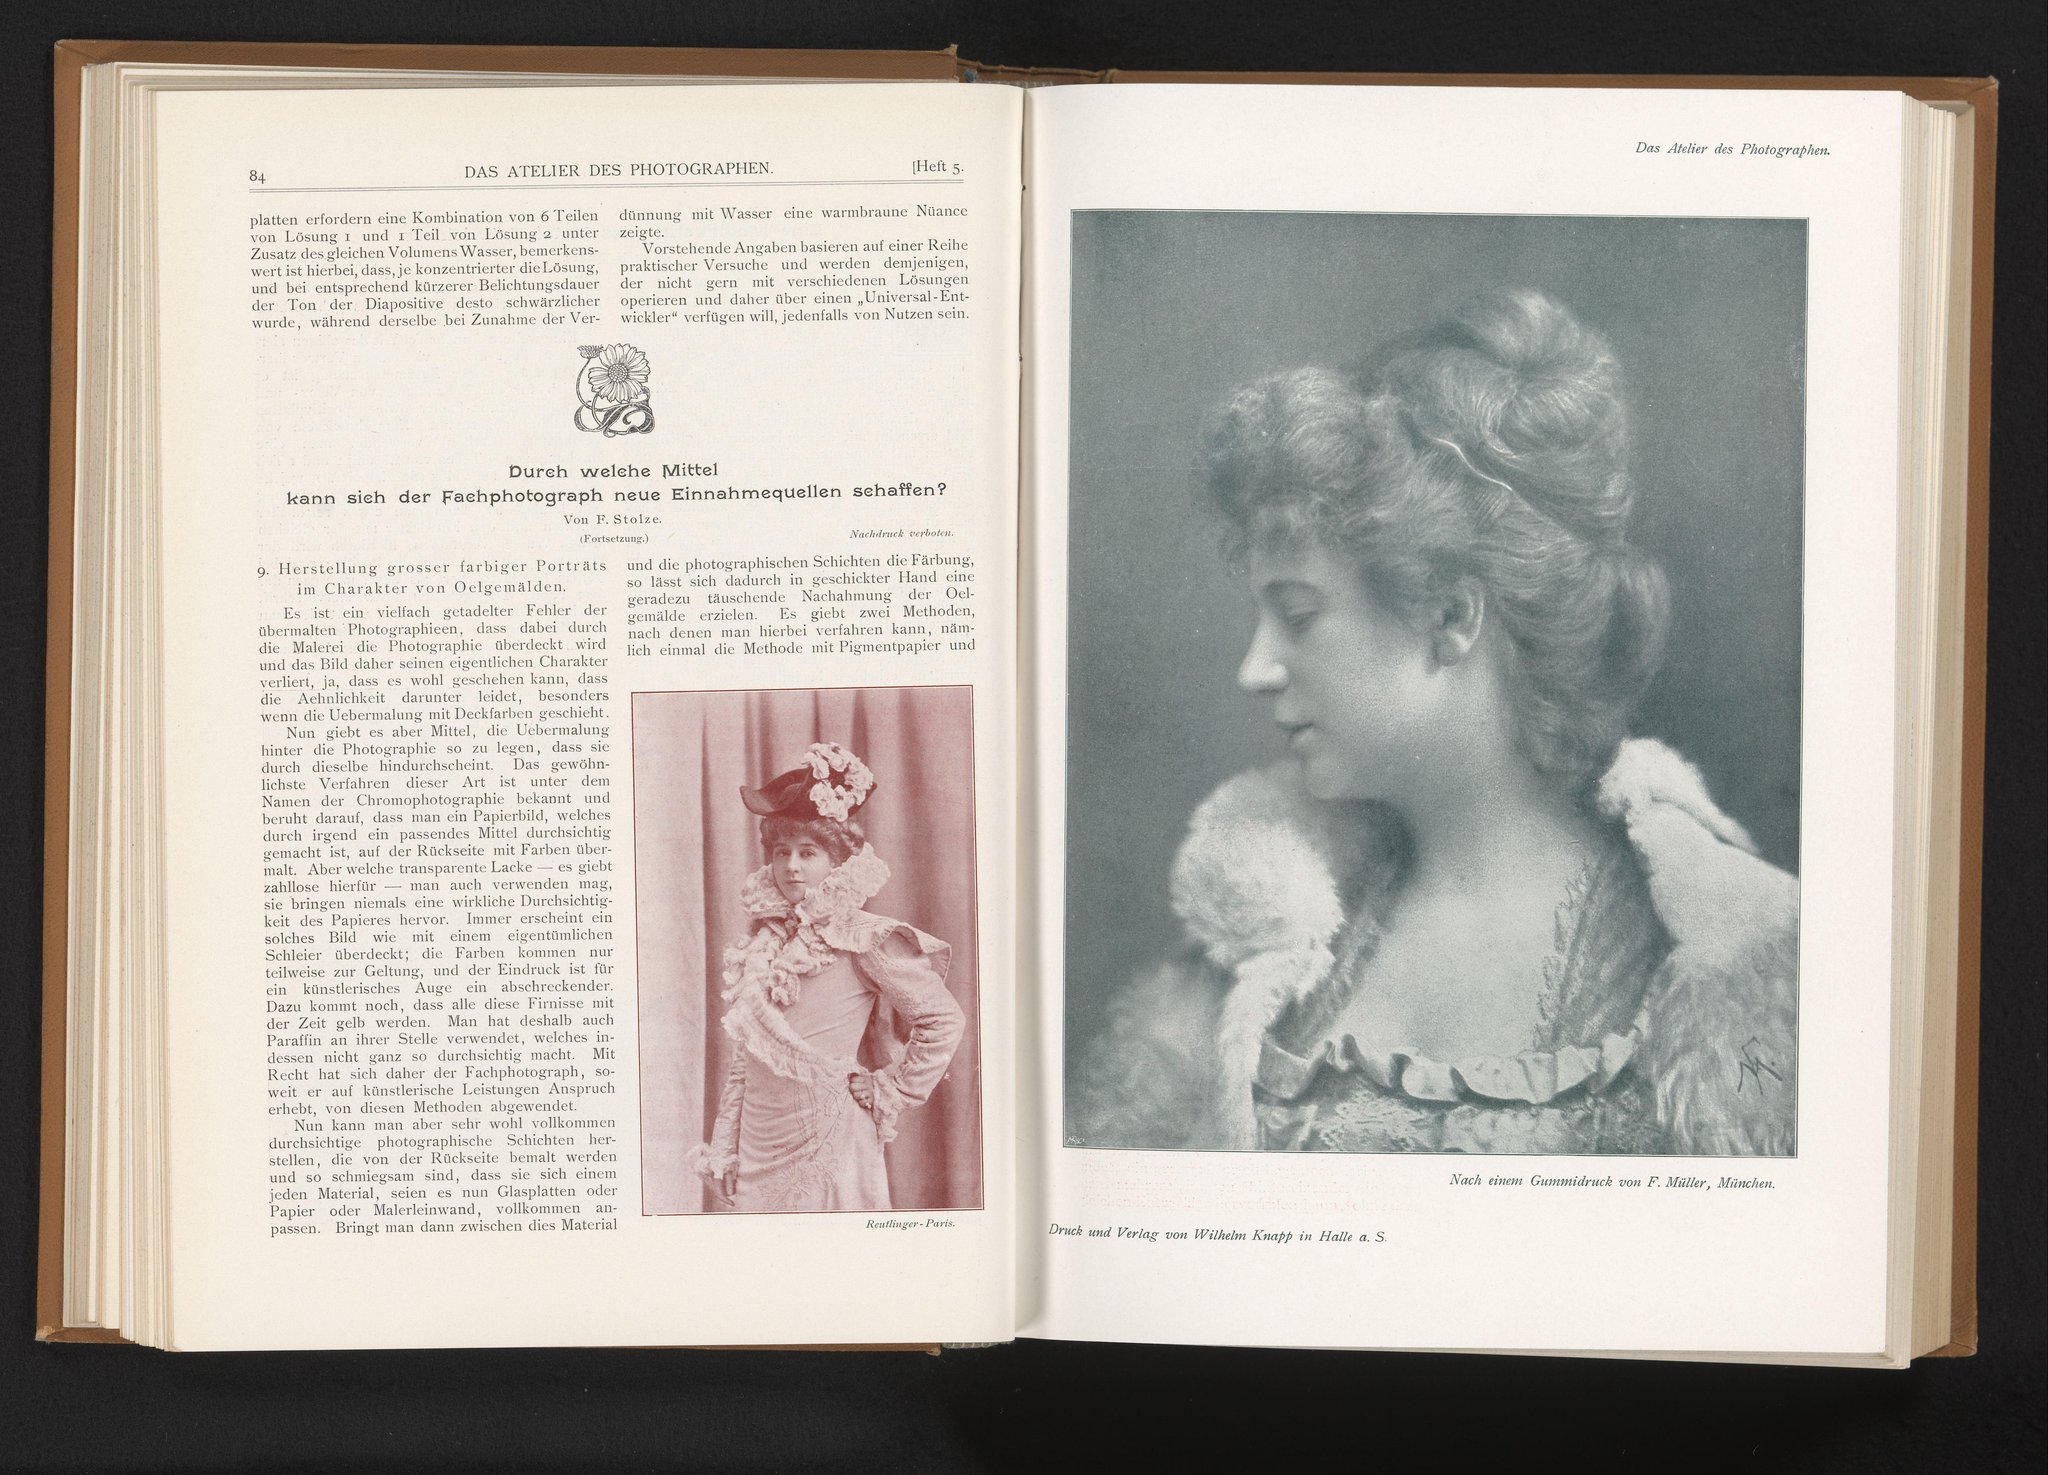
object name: photomechanical print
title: Portret van een onbekende vrouw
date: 1895-1900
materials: paper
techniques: autotype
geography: munich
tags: historical persons - bb - woman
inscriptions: inscription: ‘Das Atelier des Photographen.’